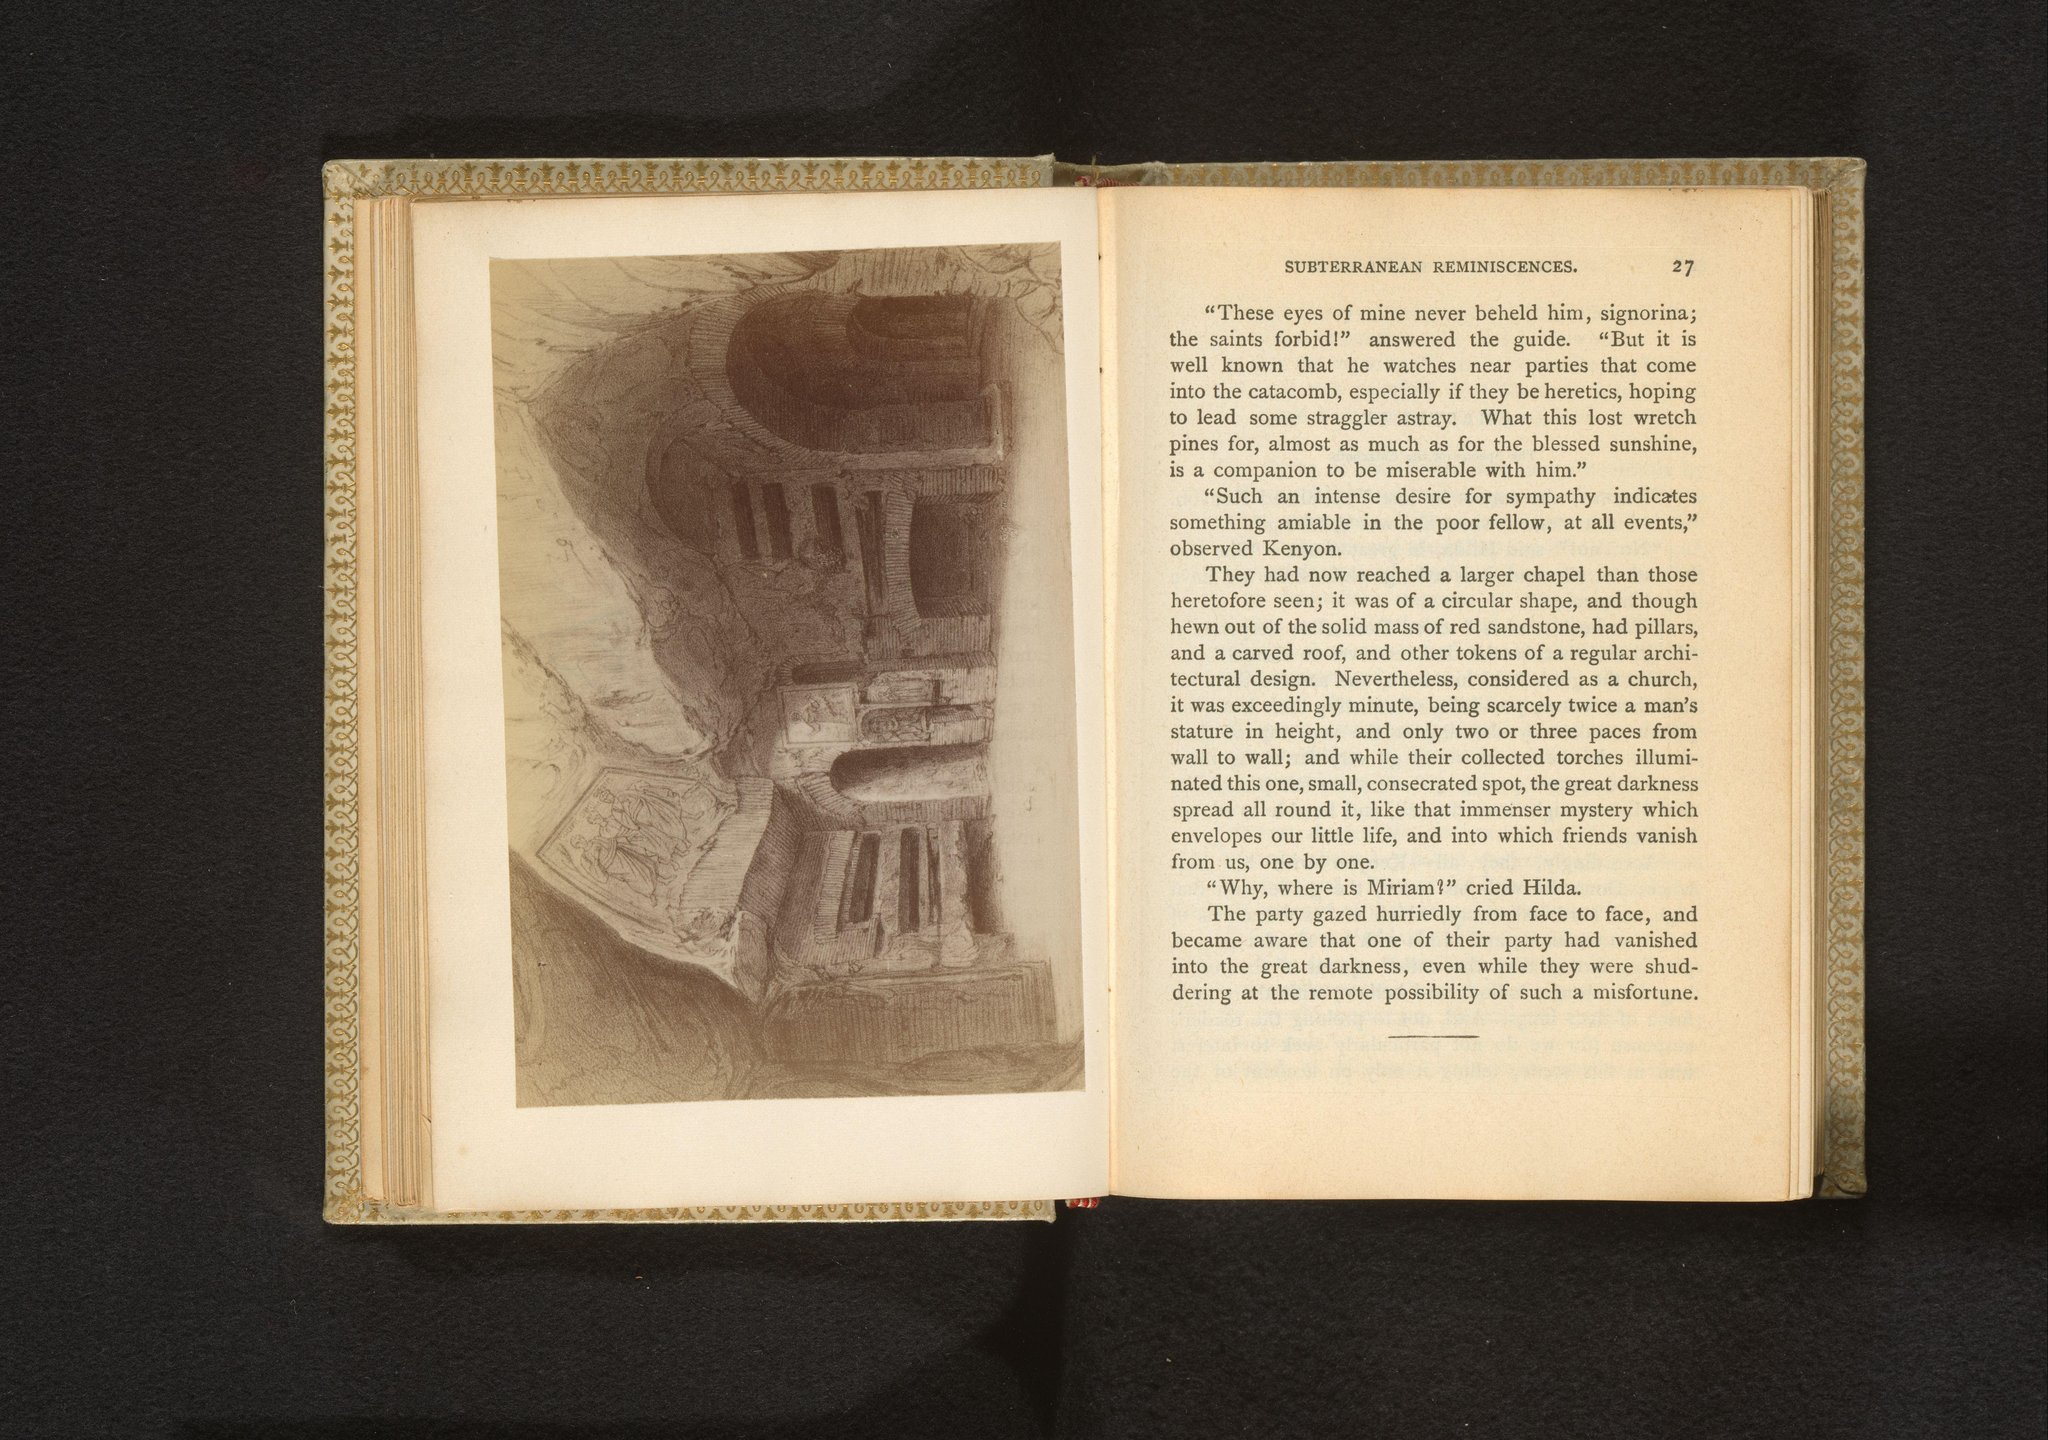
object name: photograph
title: Fotoreproductie van een tekening van vermoedelijk de catacomben van Sint-Calixtus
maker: Anonymous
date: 1850-1860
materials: photographic support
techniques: albumen print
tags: ancient grave forms, rome